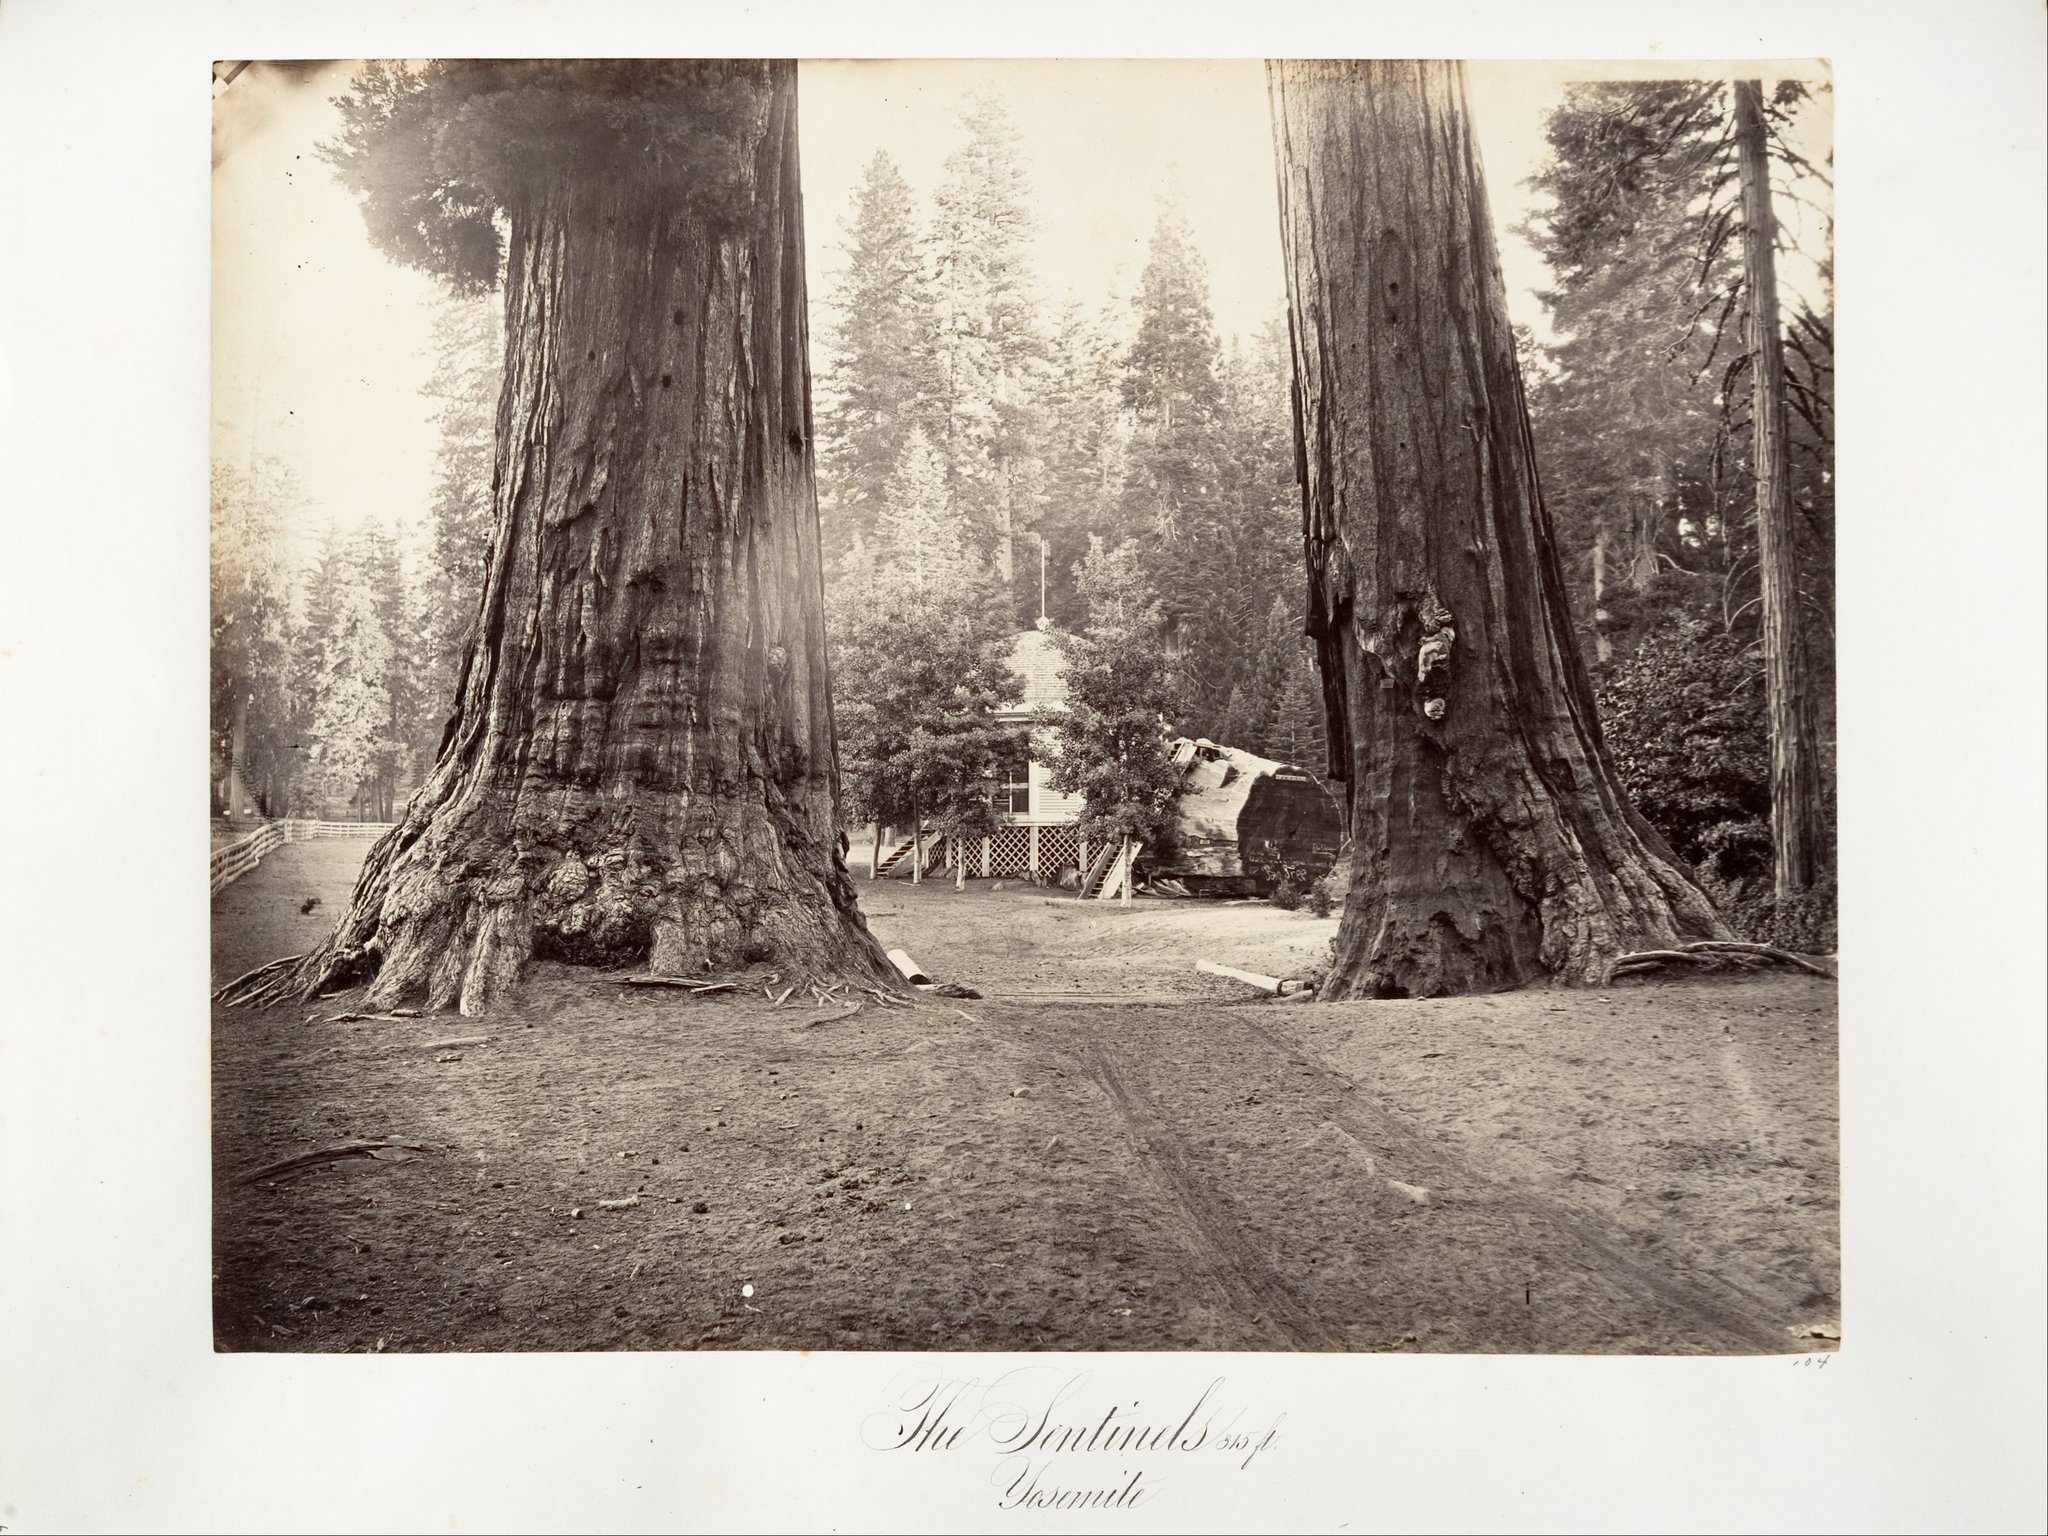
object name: photograph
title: The Sentinels, 315 feet, Yosemite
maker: carleton e. watkins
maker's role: artist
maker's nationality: american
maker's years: 1829-1916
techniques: albumen silver print, glass negative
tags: trees